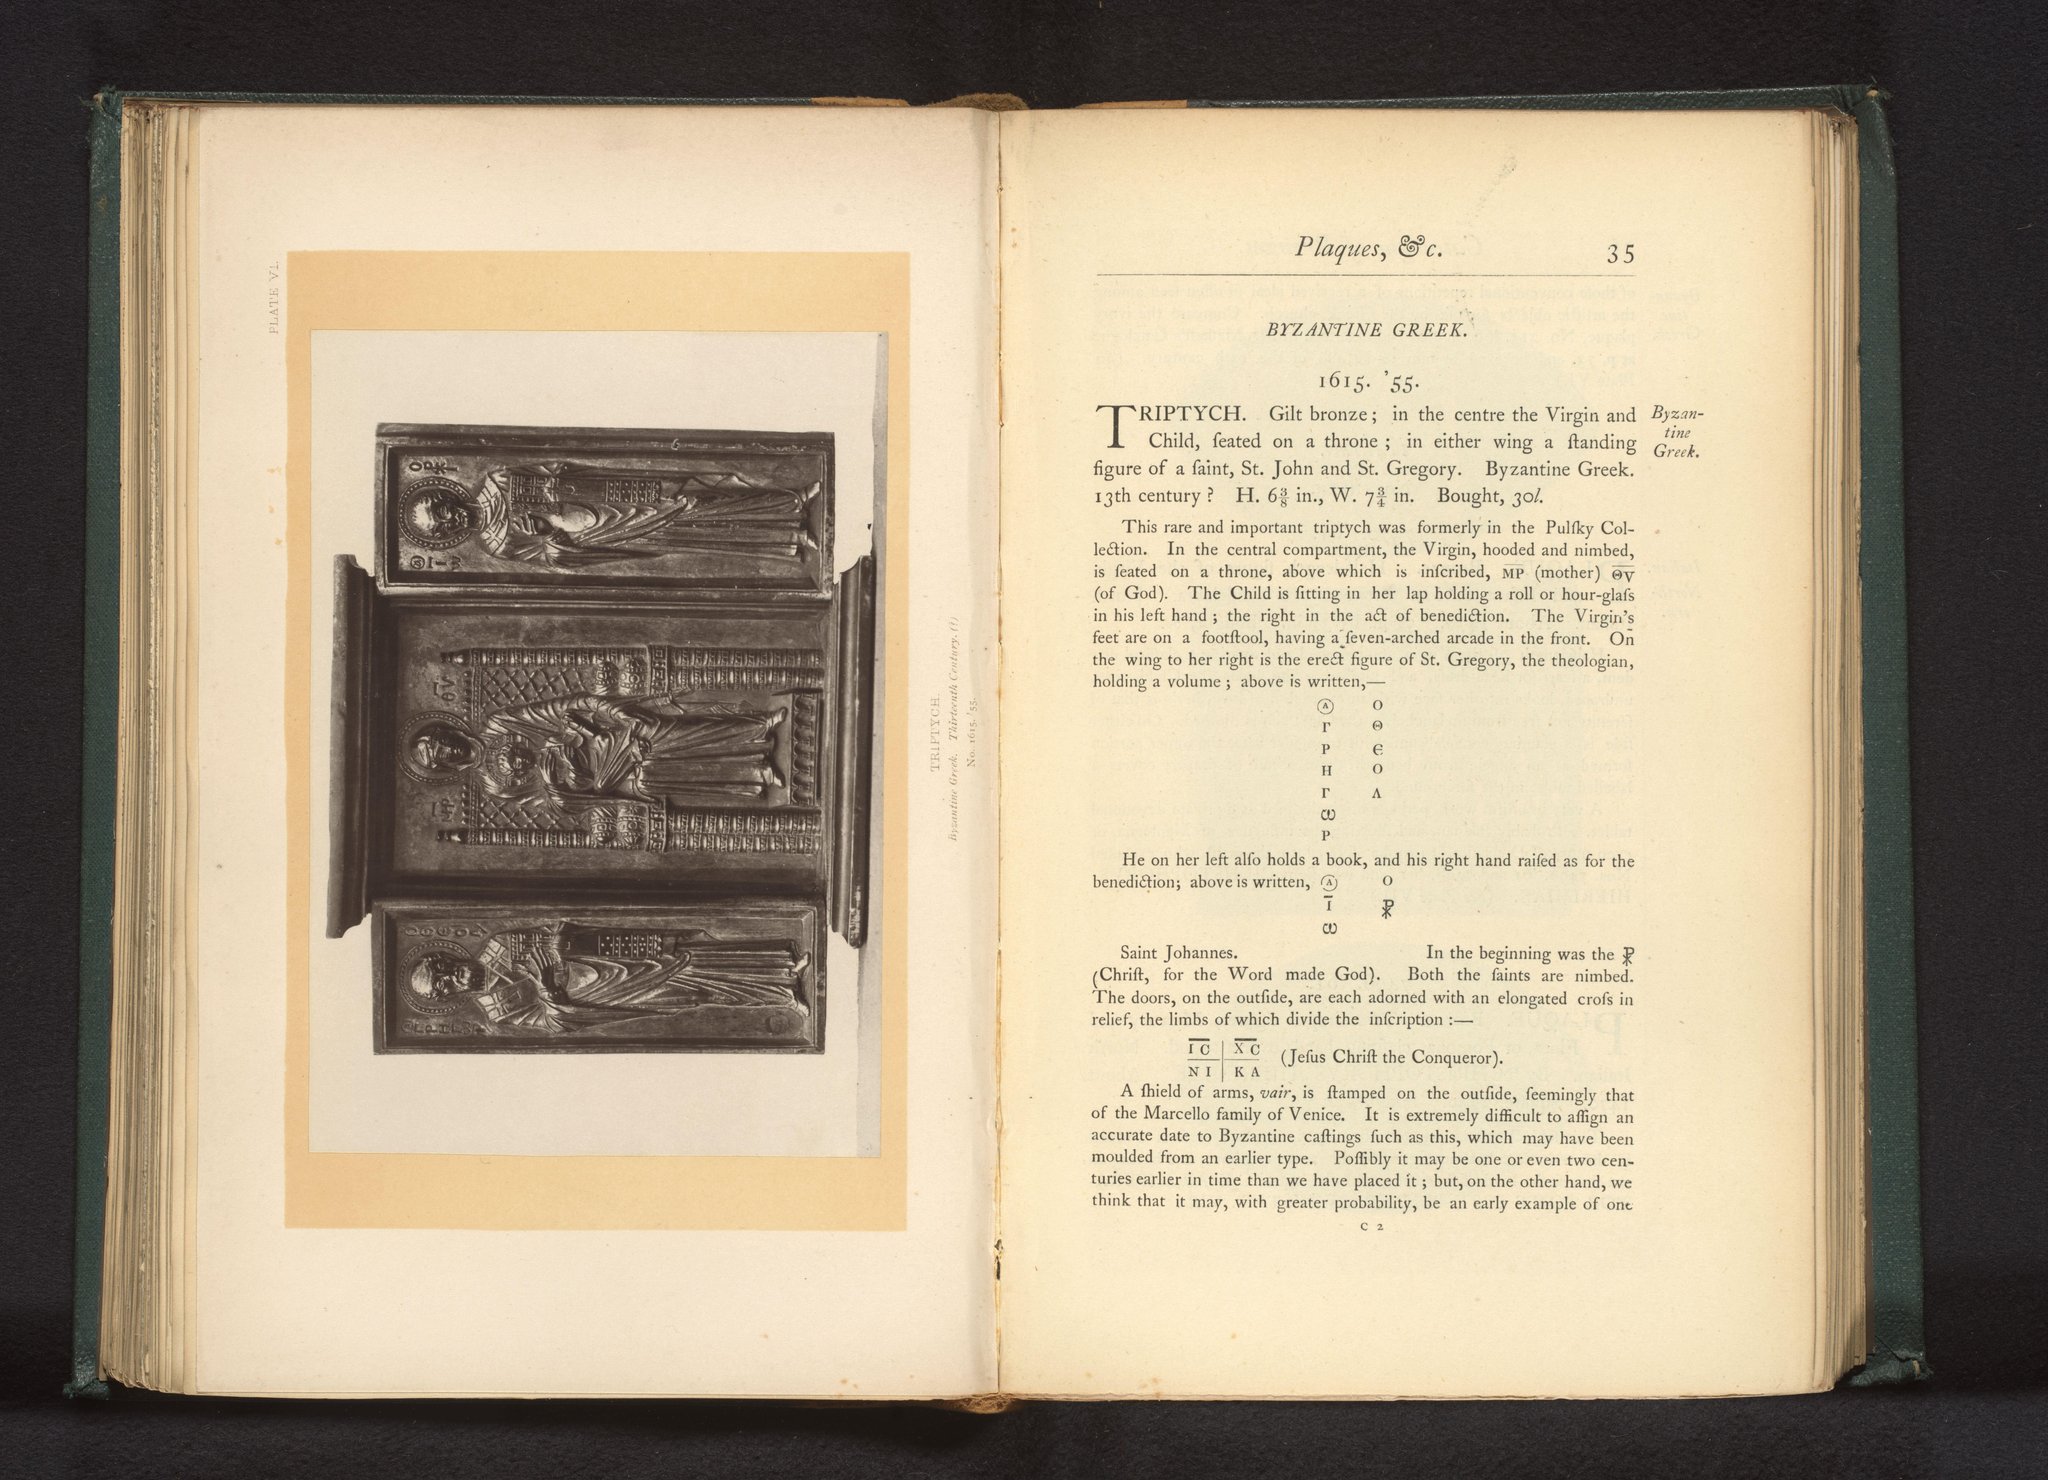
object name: page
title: Triptych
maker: Anonymous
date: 1869-1876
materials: paper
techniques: woodburytype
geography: london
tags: madonna: i.e. mary with the christ-child, pope gregory the great; possible attributes: dove, emperor trajan, life and acts of john the evangelist, sculpture (+ relief ~ sculpture)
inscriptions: inscription: ‘Byzantine Greek. Thirteenth Century (?)’, number: ‘Plate VI.’, number: ‘No. 1615. '55.’